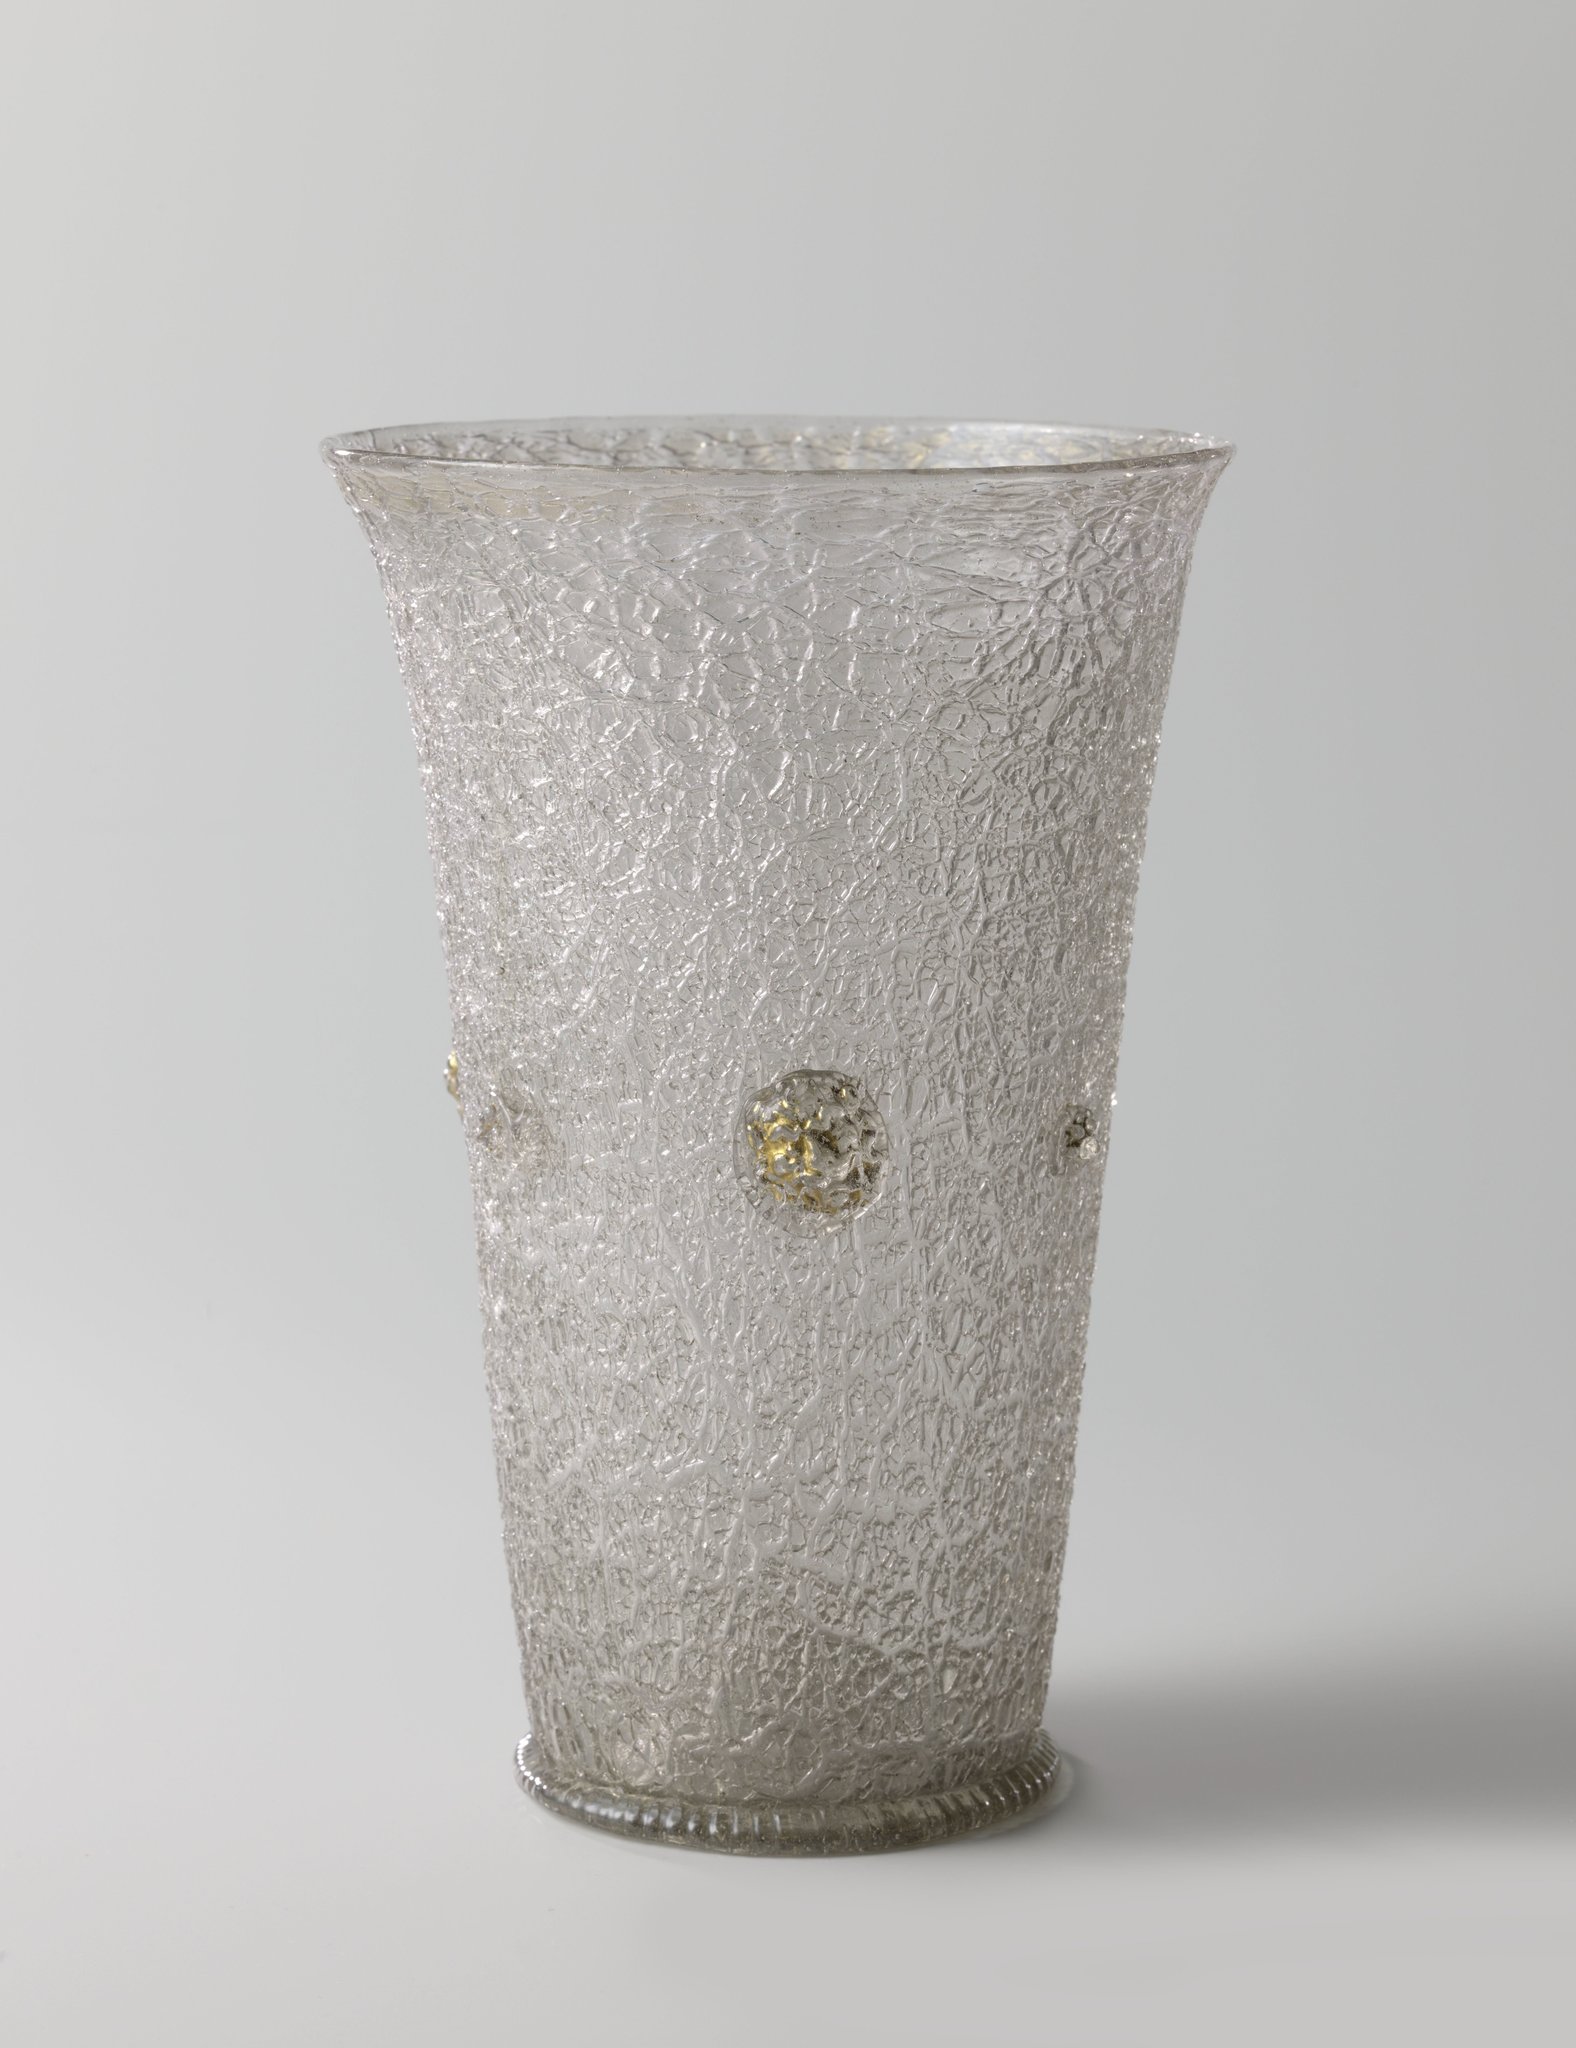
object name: cup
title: Beker van ijsglas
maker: Anonymous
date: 1550-1650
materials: glass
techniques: façon de venise, gilding, glassblowing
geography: low countries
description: Beker van ijsglas, met ingestoken bodem. Geribde standring van helder glas. Bekervormig lichaam, waarop ter halver hoogte drie mascarons en drie kleine noppen zijn aangebracht. Resten van verguldsel op de noppen en langs de bovenrand.